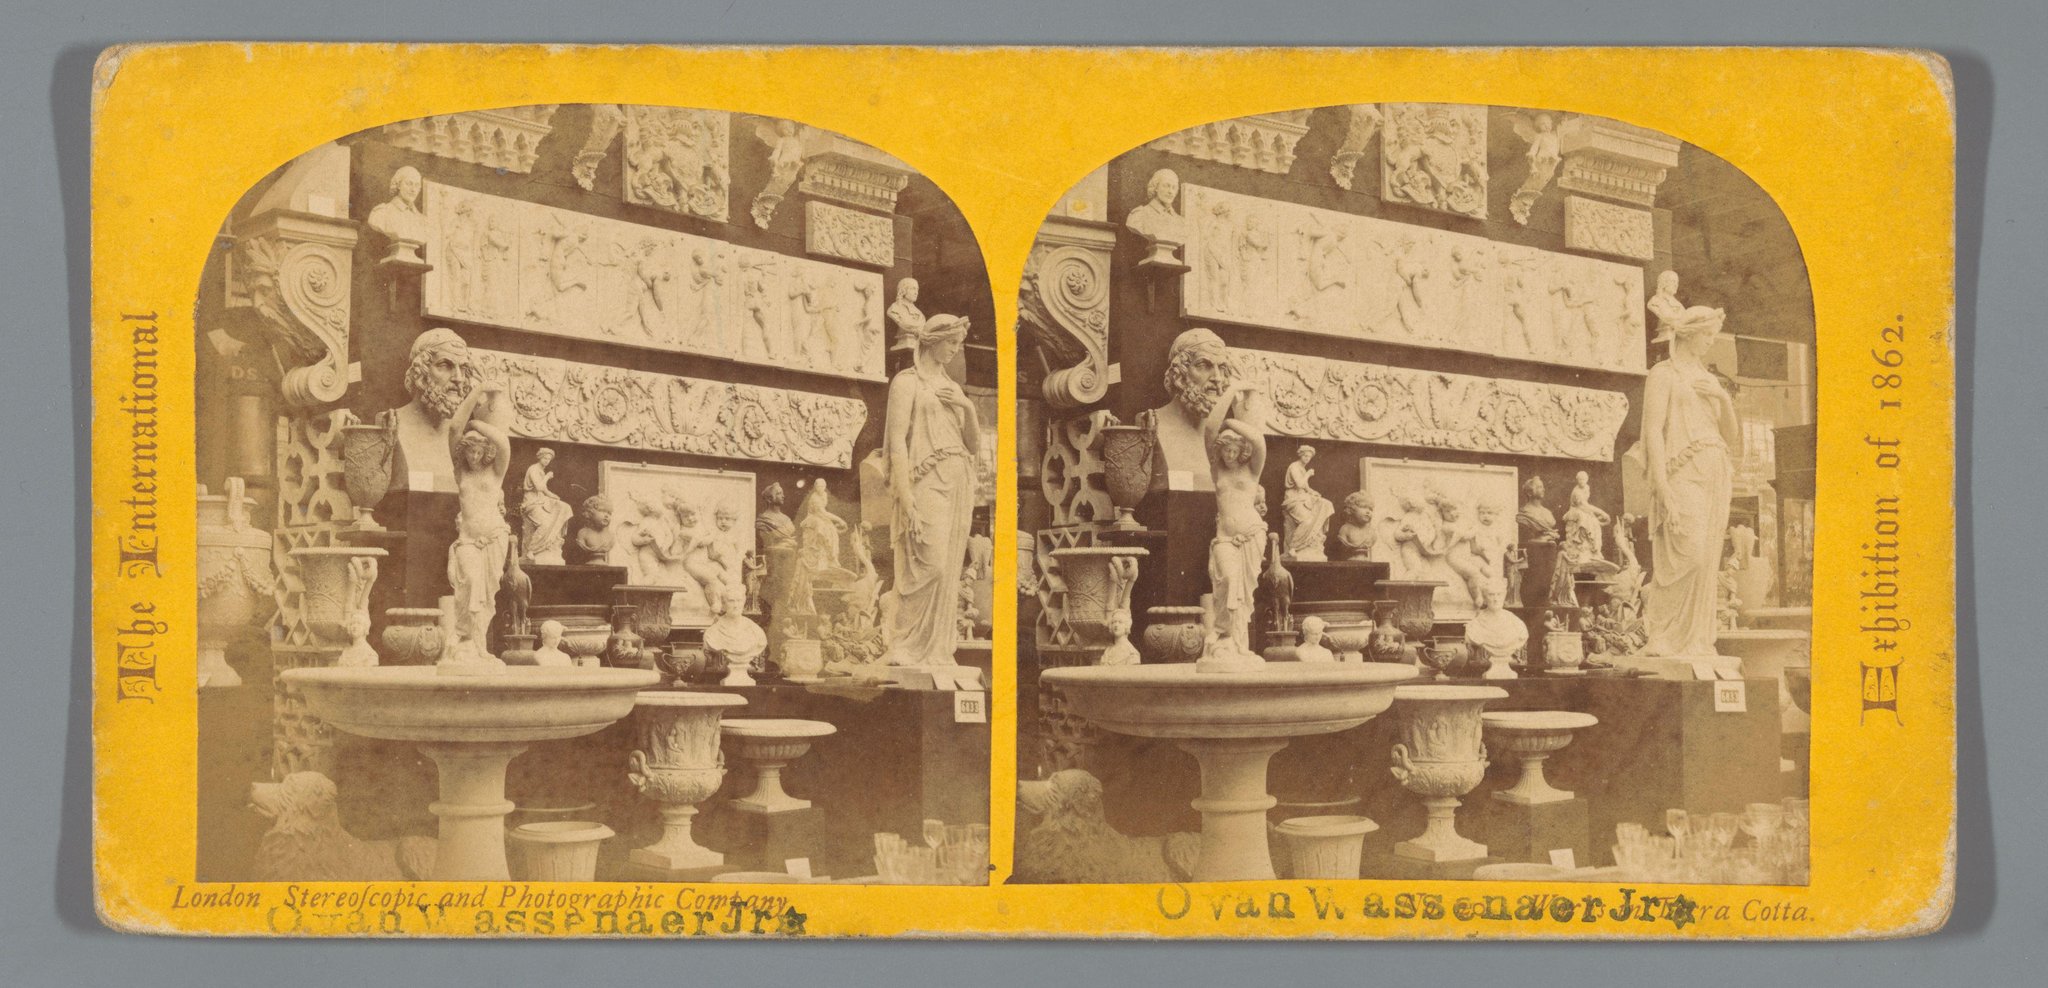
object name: stereograph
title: Works in Terra Cotta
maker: william england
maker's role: fotograaf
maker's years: 1816-1896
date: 1862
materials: cardboard, paper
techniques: albumen print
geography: london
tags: world fair, world exhibition, container of ceramics: jar, jug, pot, vase, london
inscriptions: collector's mark: ‘O. van Wassenaer Jr *’, number: ‘No. 20’, inscription: ‘f-.50’, inscription: ‘V8’